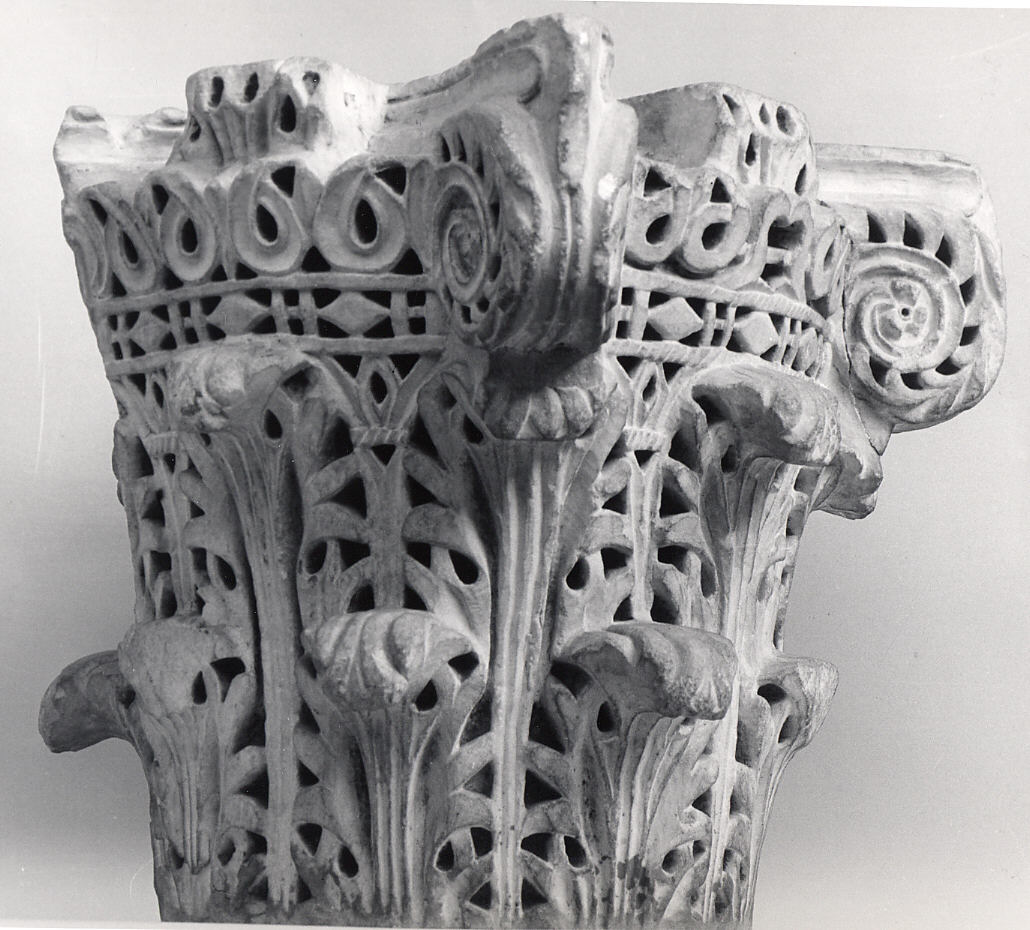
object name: capital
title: Capital with Acanthus Leaves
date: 901-1000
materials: marble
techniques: carving, relief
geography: spain